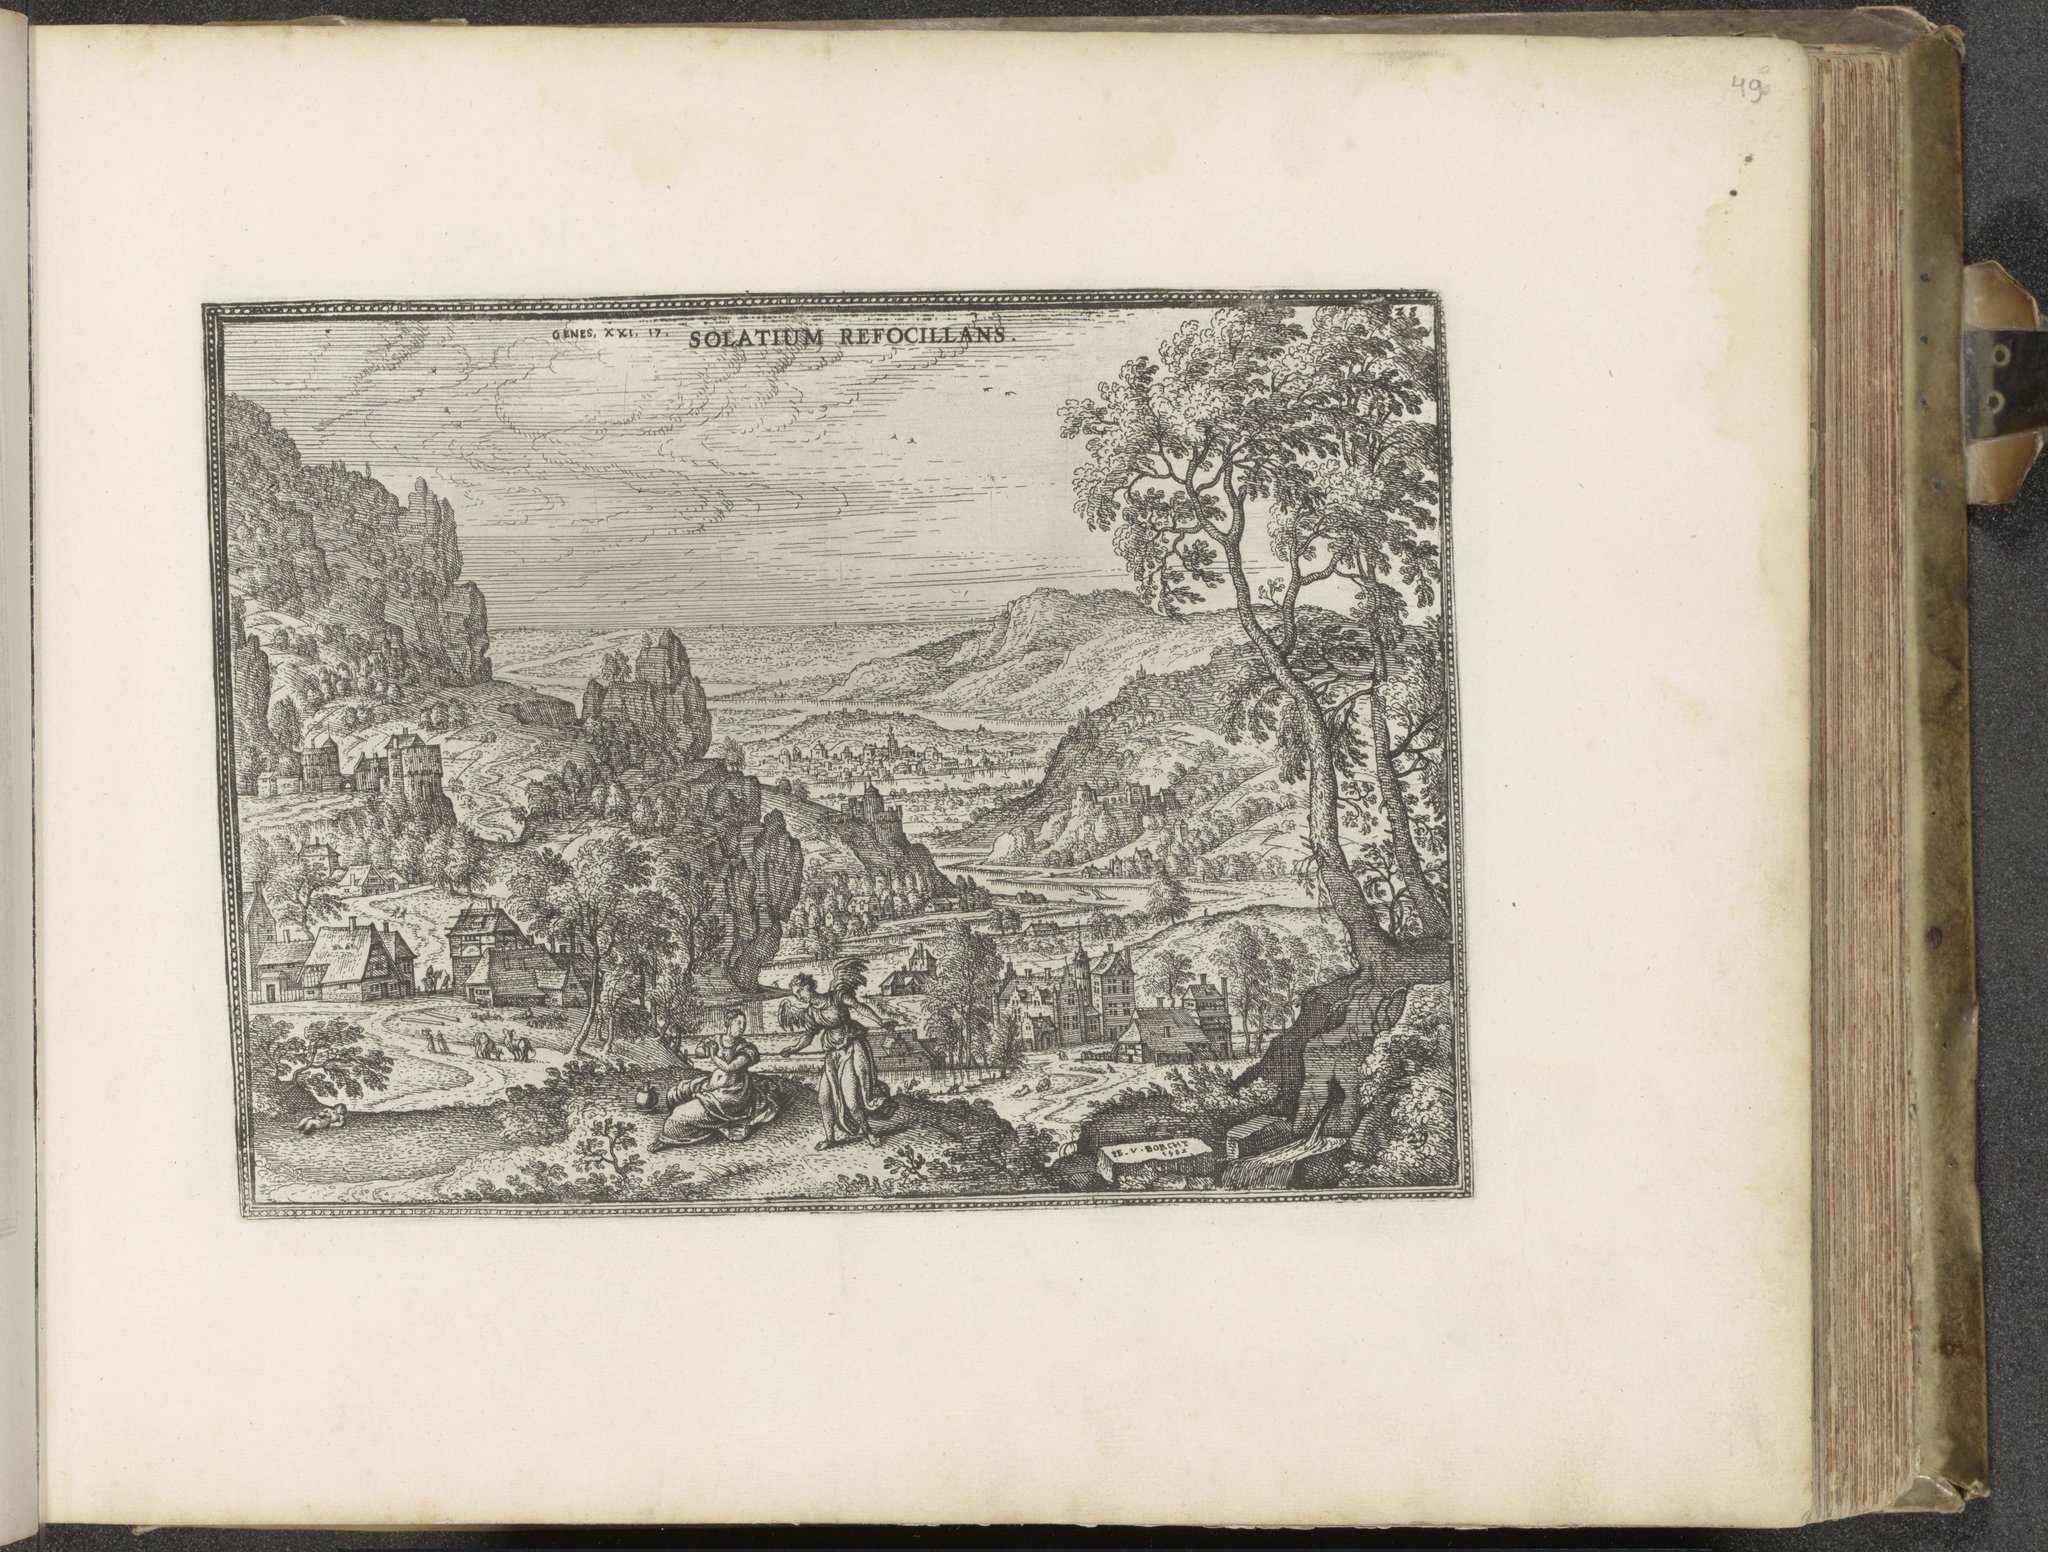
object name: album leaf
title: Solatium refocillans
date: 1582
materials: paper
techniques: etching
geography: amsterdam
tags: city-view, and landscape with man-made constructions, landscapes, river, old testament, hagar and ishmael in the wilderness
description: Landschap met in het midden Hagar, de tweede vrouw van Abraham. Linksonder ligt haar kind Ismaël die zij bij gebrek aan water achterliet onder een struik. Een engel wijst Hagar op een waterbron achter haar (Gen. 21:17). De prent maakt deel uit van een album.